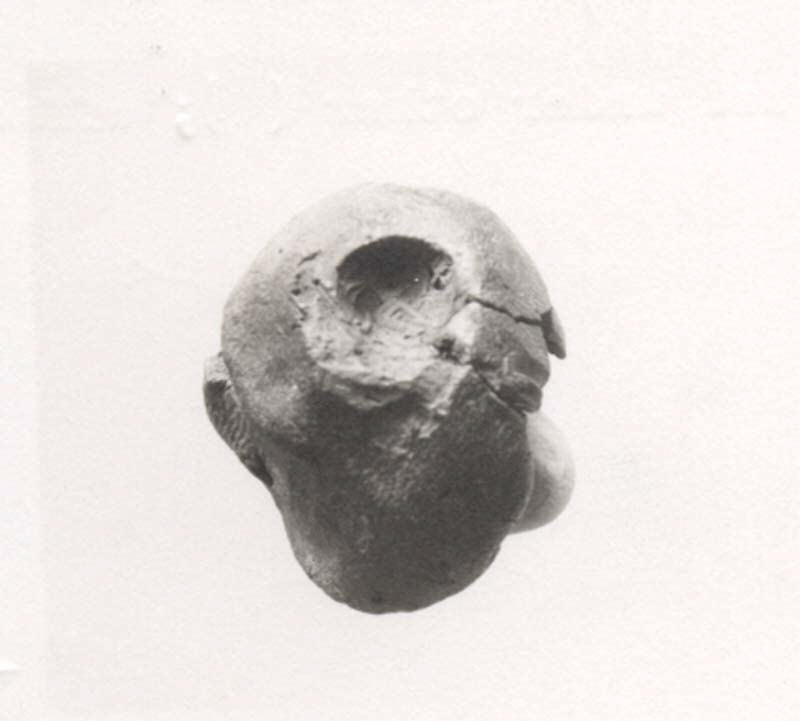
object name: sealing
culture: sasanian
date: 601-700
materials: clay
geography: iran